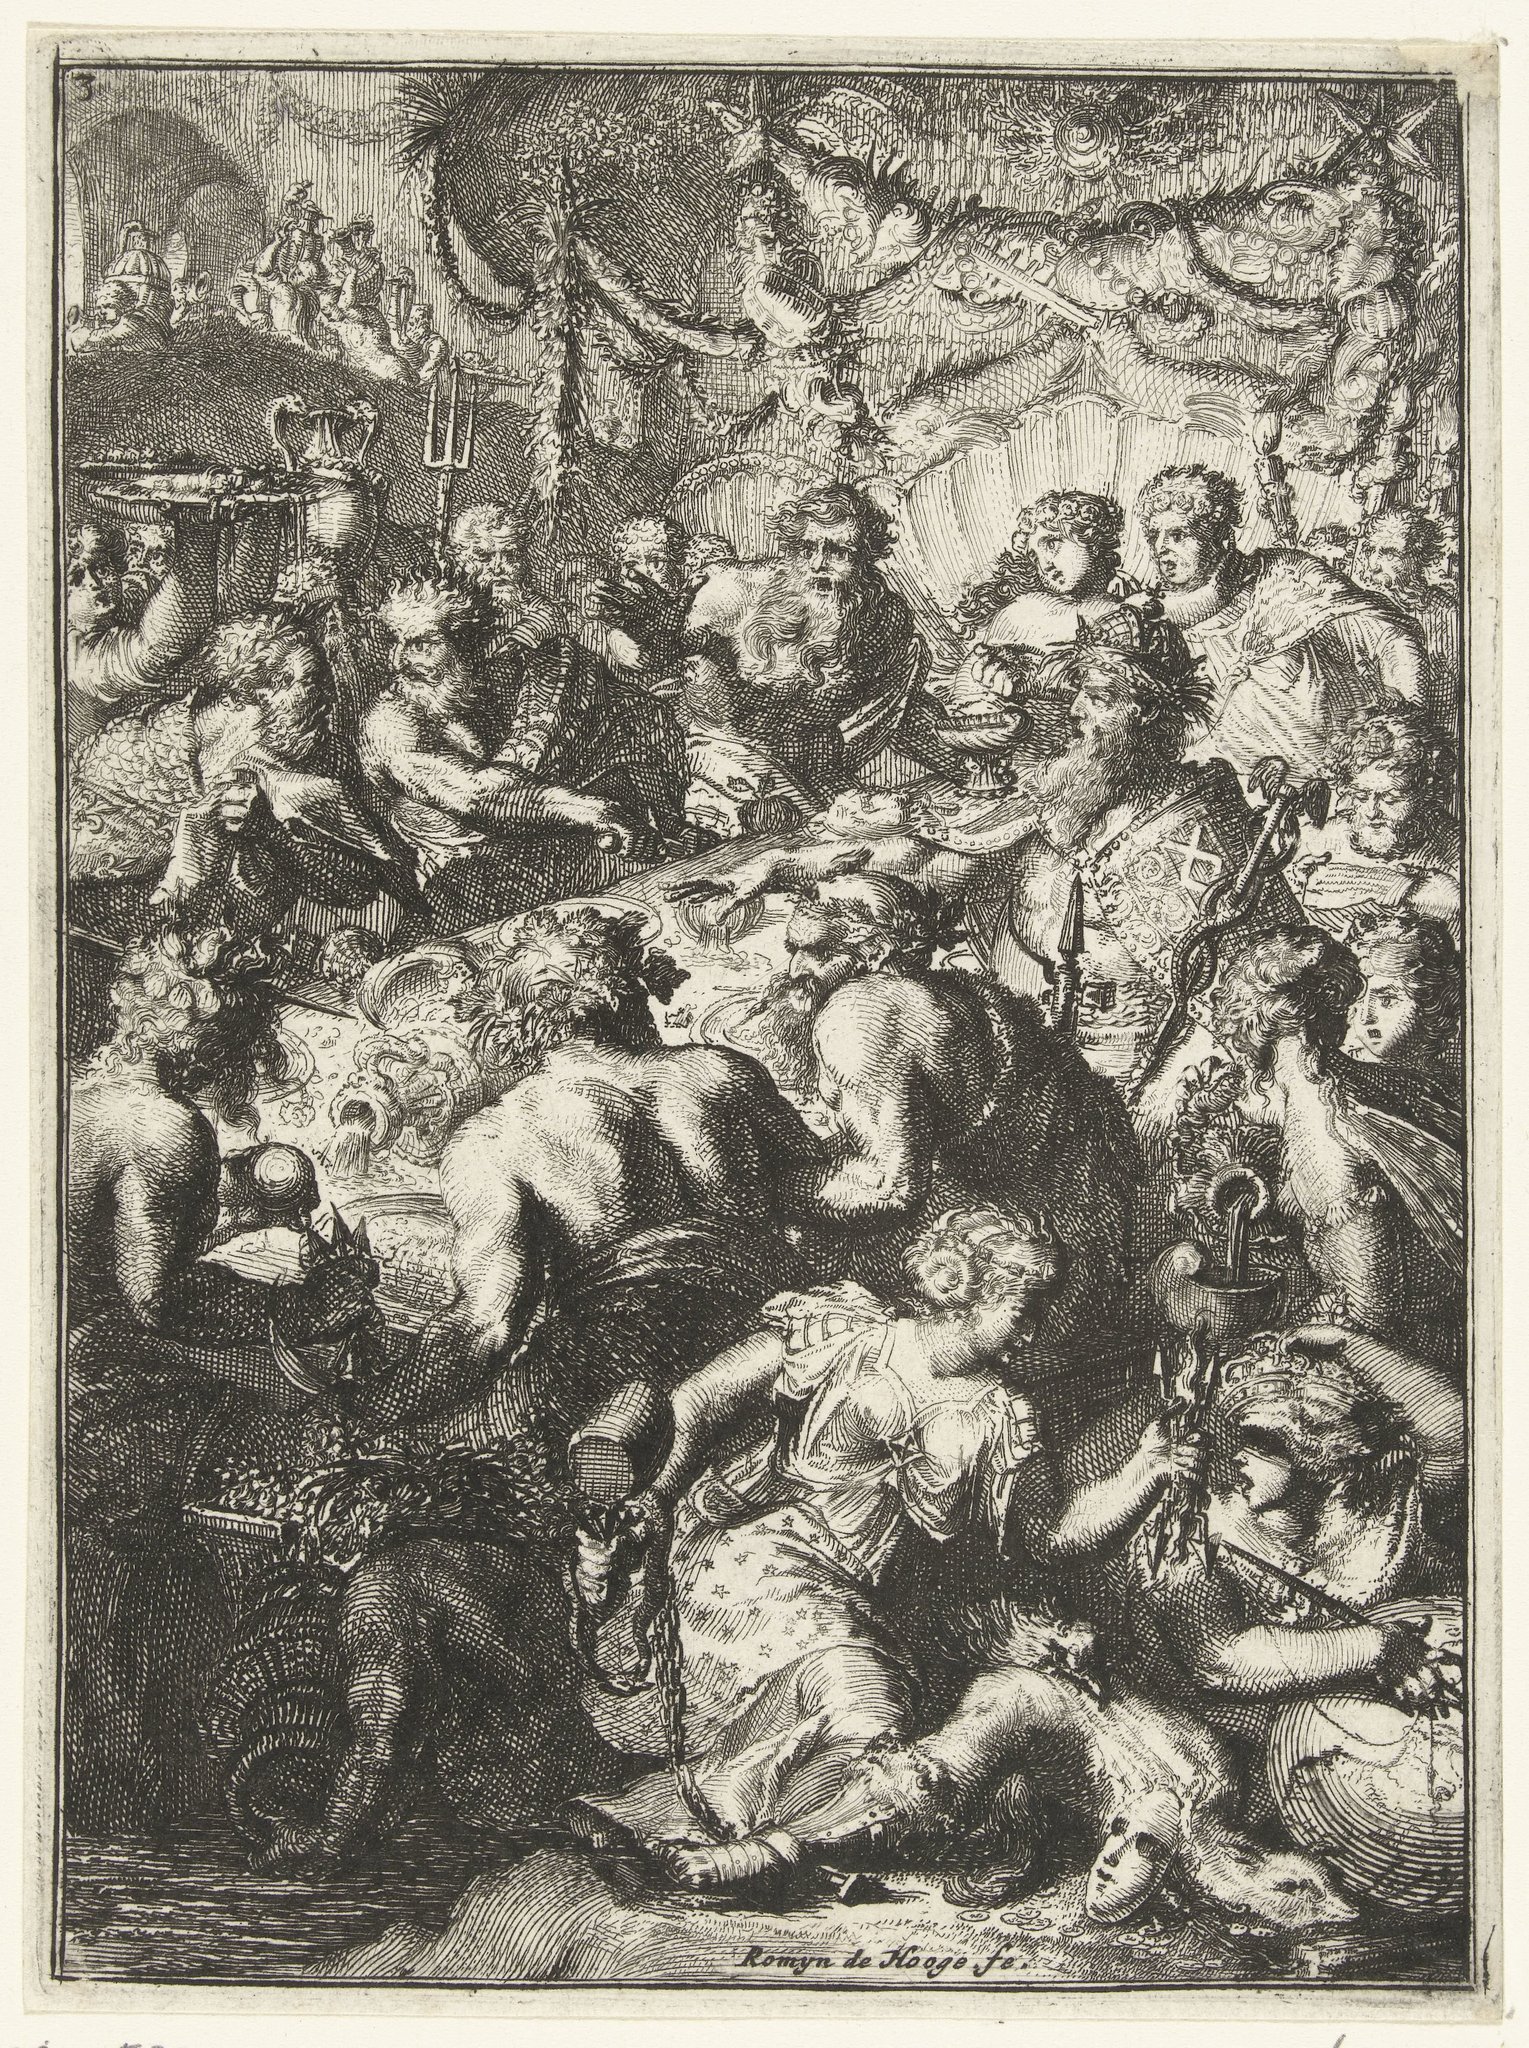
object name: print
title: Titelprent van Boek 3 van De Ystroom (1671) van Antonides van der Goes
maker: romeyn de hooghe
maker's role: draughtsman, goldsmith, painter, print maker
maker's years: 1645-1708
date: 1671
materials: paper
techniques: engraving, etching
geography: netherlands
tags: river personified, 'fiumi' (ripa), gods of the waters: neptune and his environment, meetings and dwellings of the gods (+ aggressive, unfriendly activities and relationships), the marriage-feast of peleus and thetis in or near chiron's cave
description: Titelprent van Boek 3 van De Ystroom (1671) van Antonides van der Goes. Allegorische voorstelling van het bruiloftsdiner van Peleus en Thetis. Aan de godenmaaltijd zitten personificaties van riviergoden die ruzie maken, onder andere Neptunus, het IJ (de Ygod), de Donau, de Rijn, de Amstel, de Theems, de Seine.